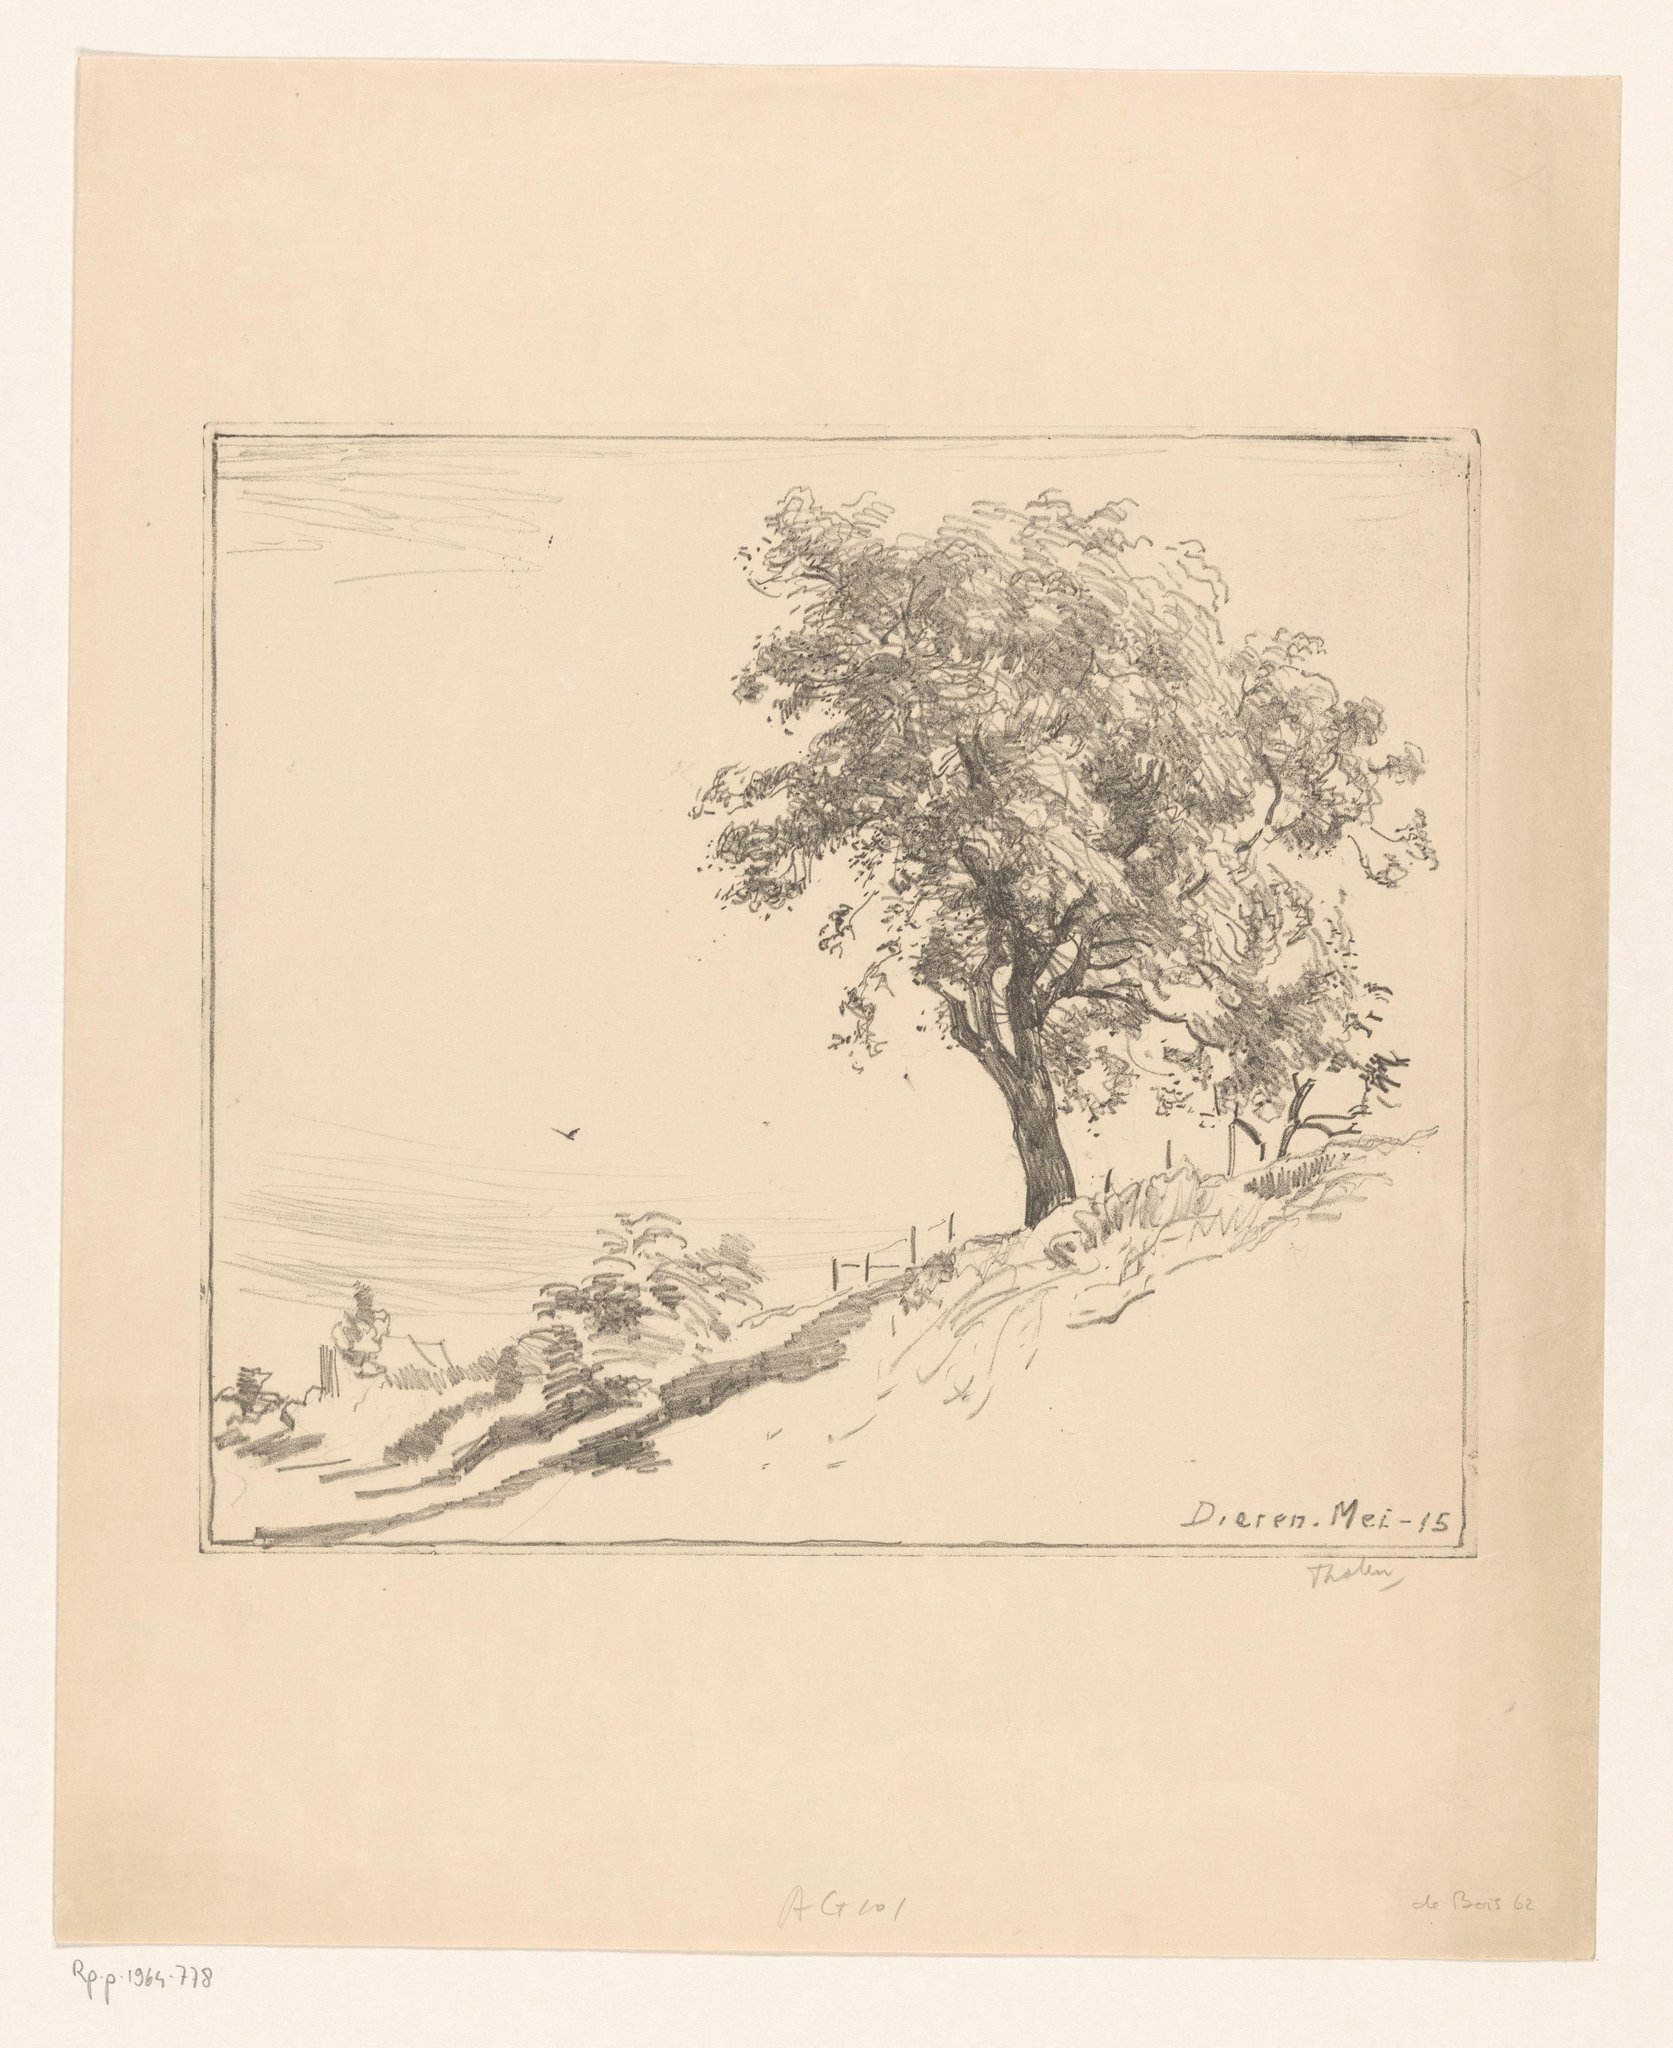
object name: print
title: Boom op dijk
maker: willem bastiaan tholen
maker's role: draughtsman, painter, print maker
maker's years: 1860-1931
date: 1905-1920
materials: paper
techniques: lithograph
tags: trees, dikes, levee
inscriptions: annotation: ‘Dieren-Mei-15’, collector's mark: Lugt 2228